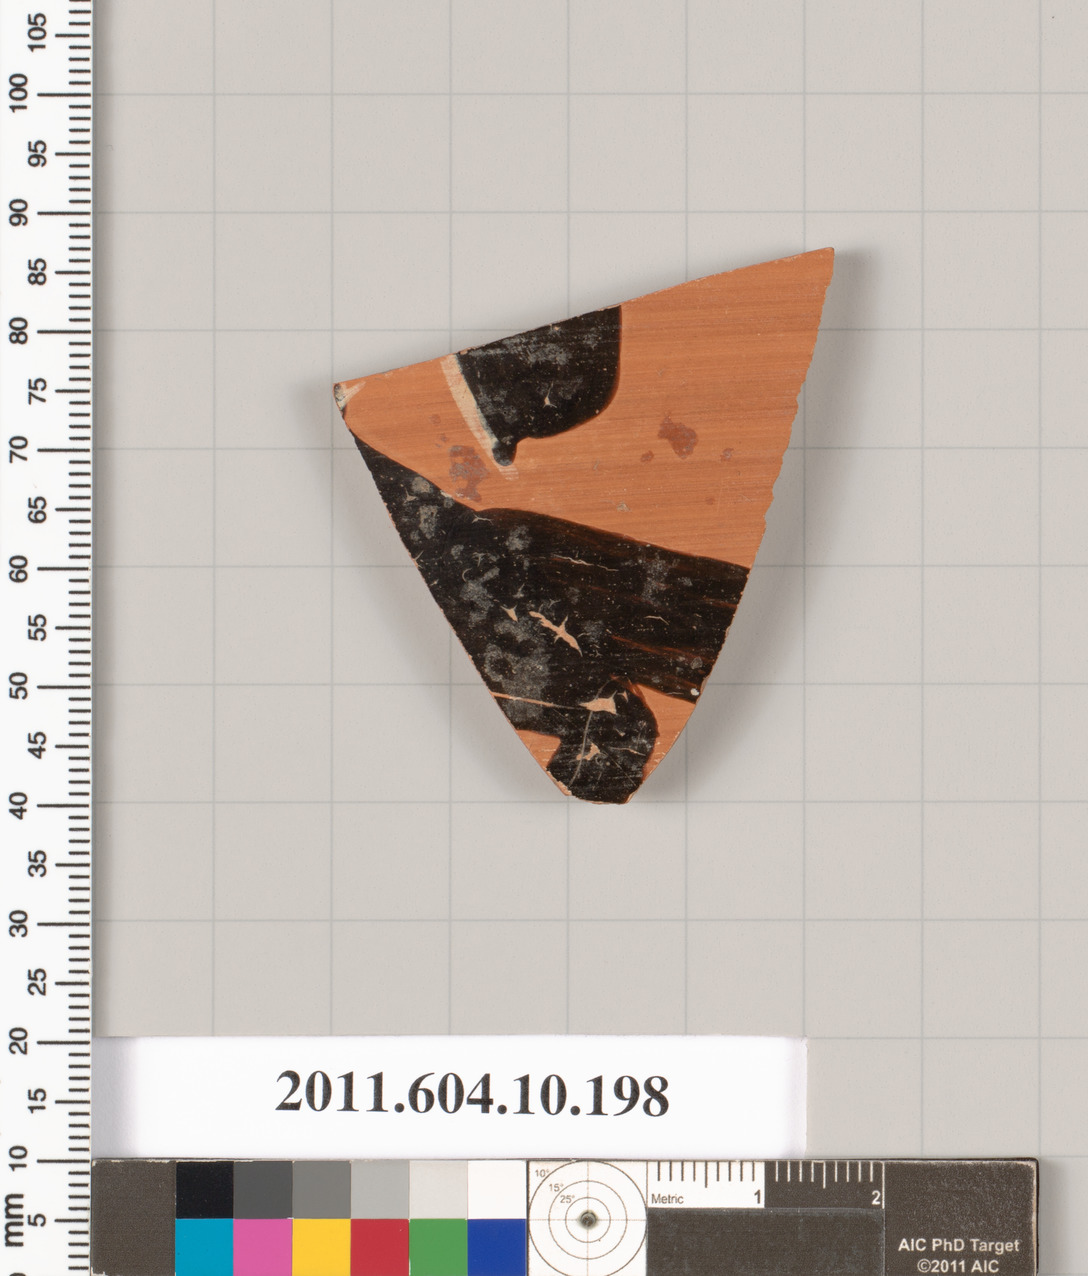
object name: undetermined closed shape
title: Terracotta fragment from a closed shape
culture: etruscan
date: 534-468 BCE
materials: terracotta